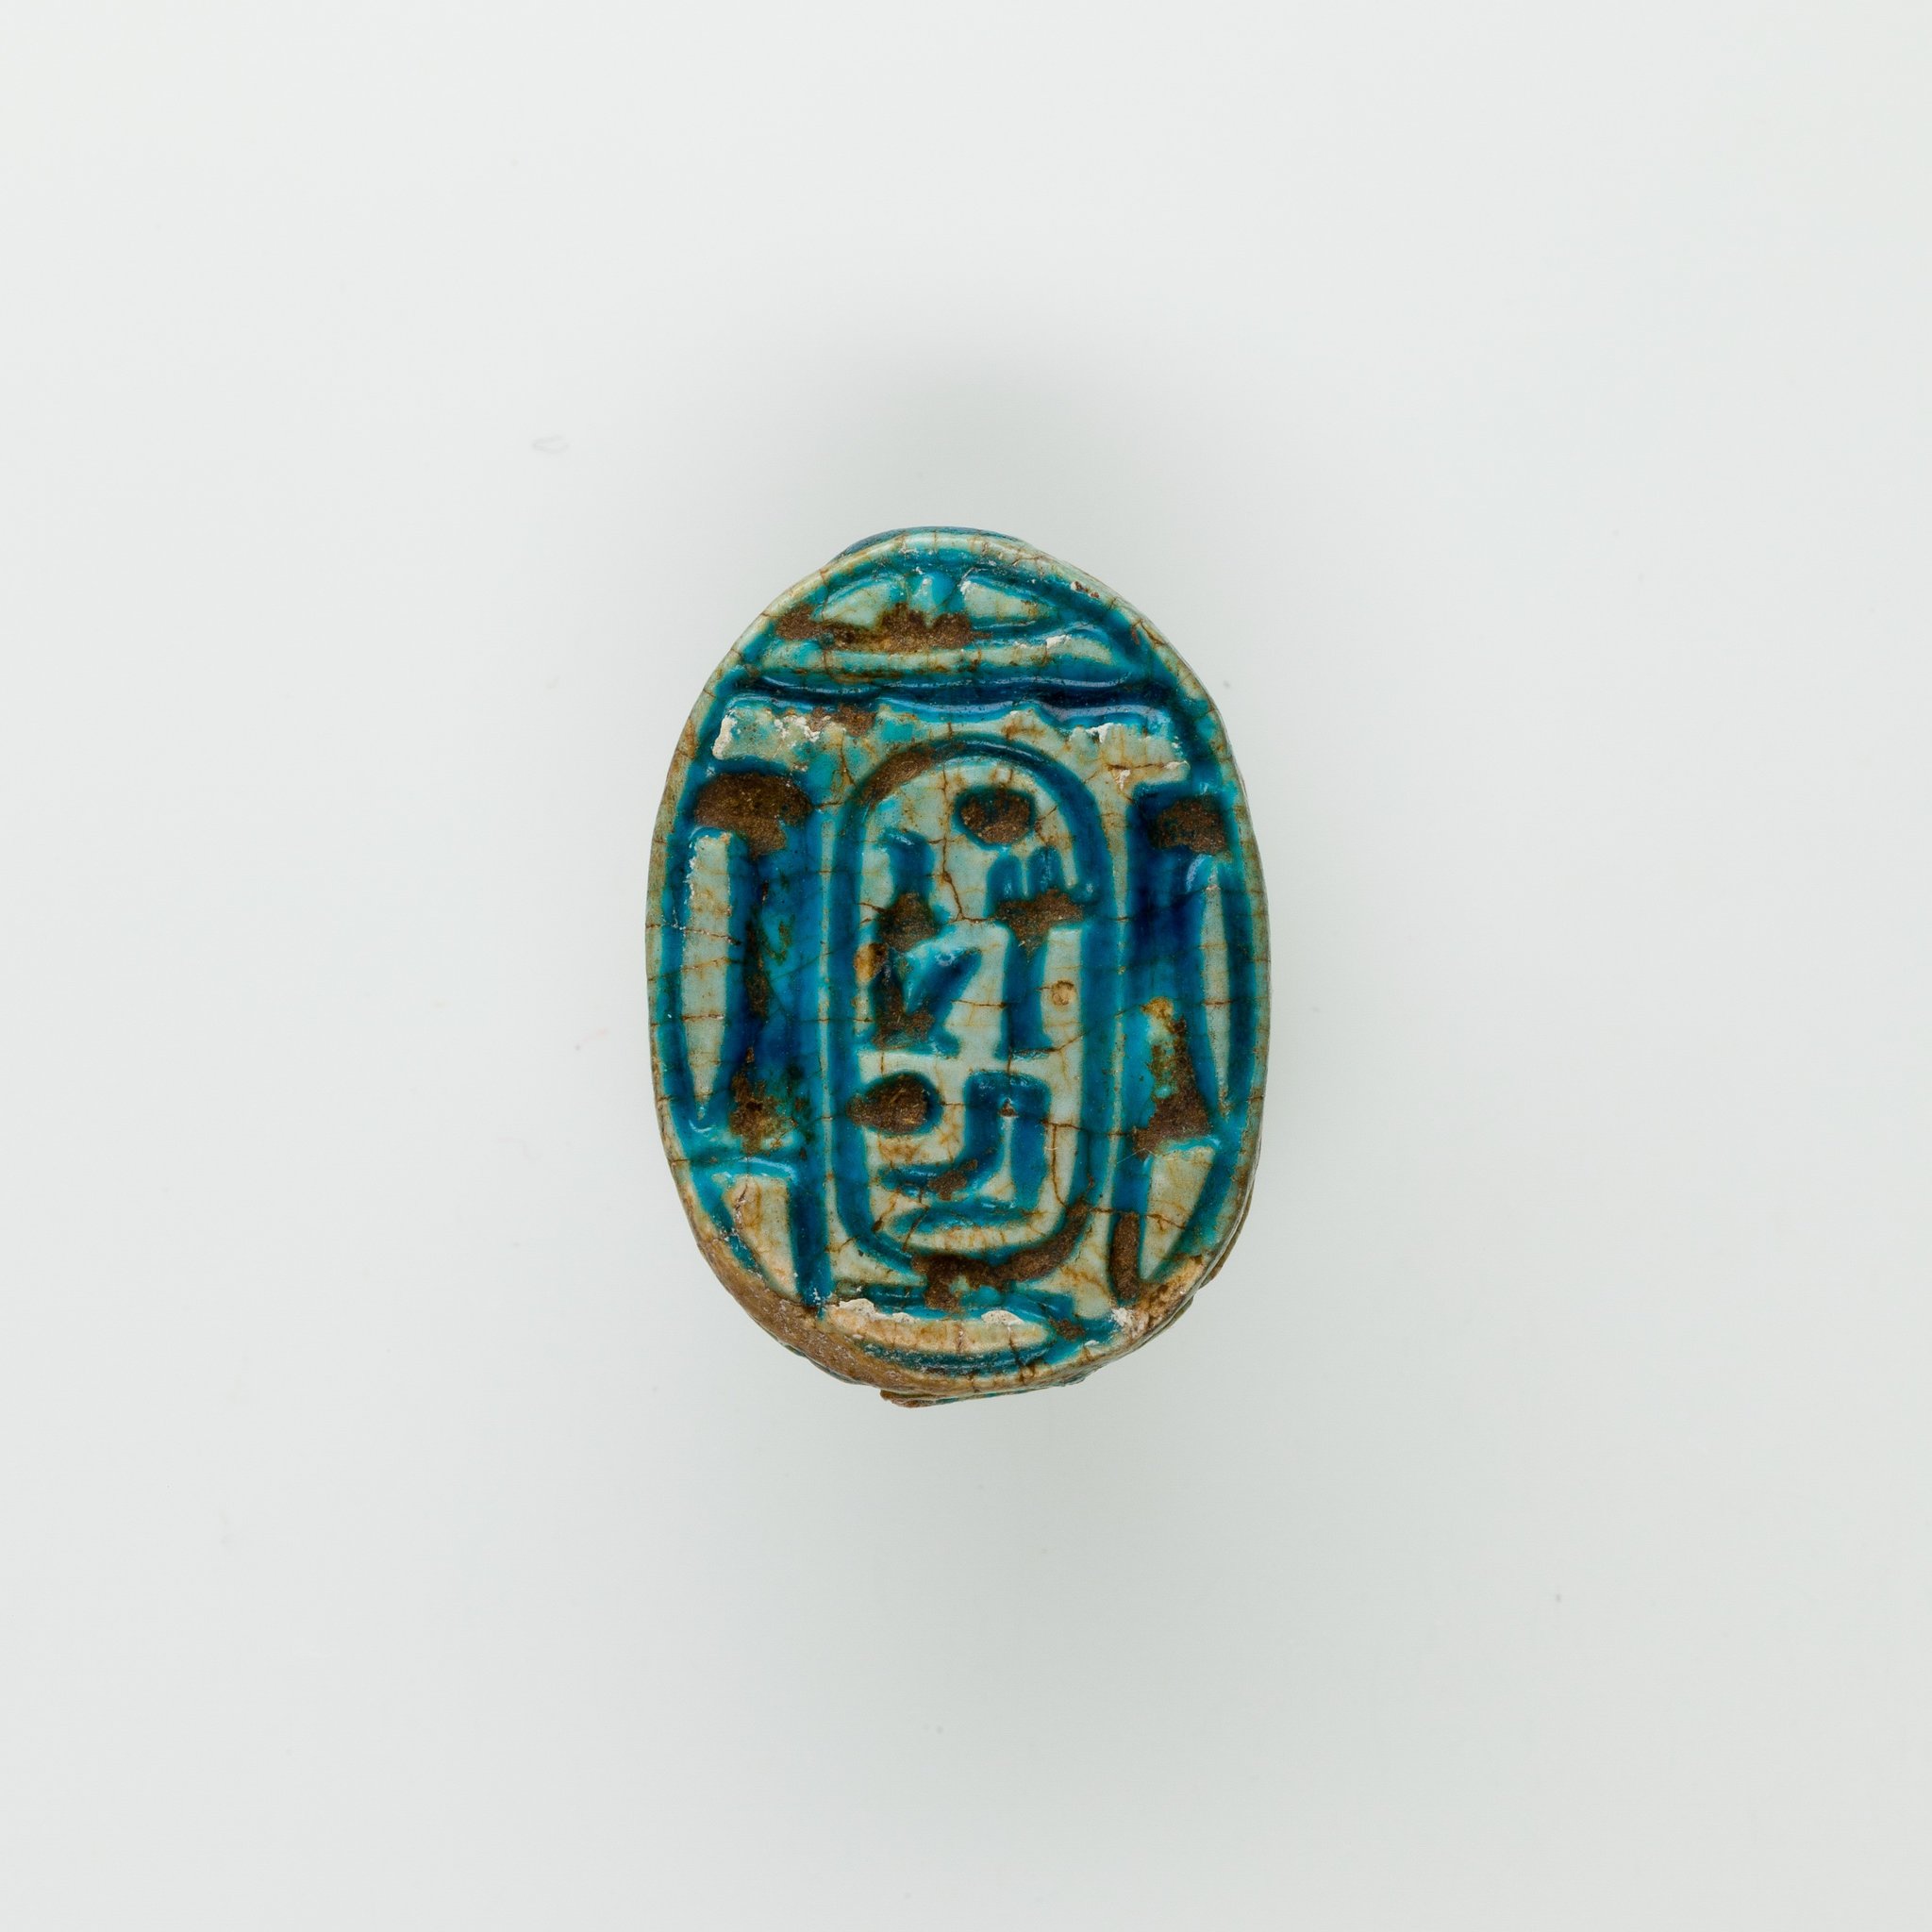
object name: scarab, ramesses ii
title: Scarab of Ramesses II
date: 1295-1070 BCE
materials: stone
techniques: glazing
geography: egypt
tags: hieroglyphs,scarabs